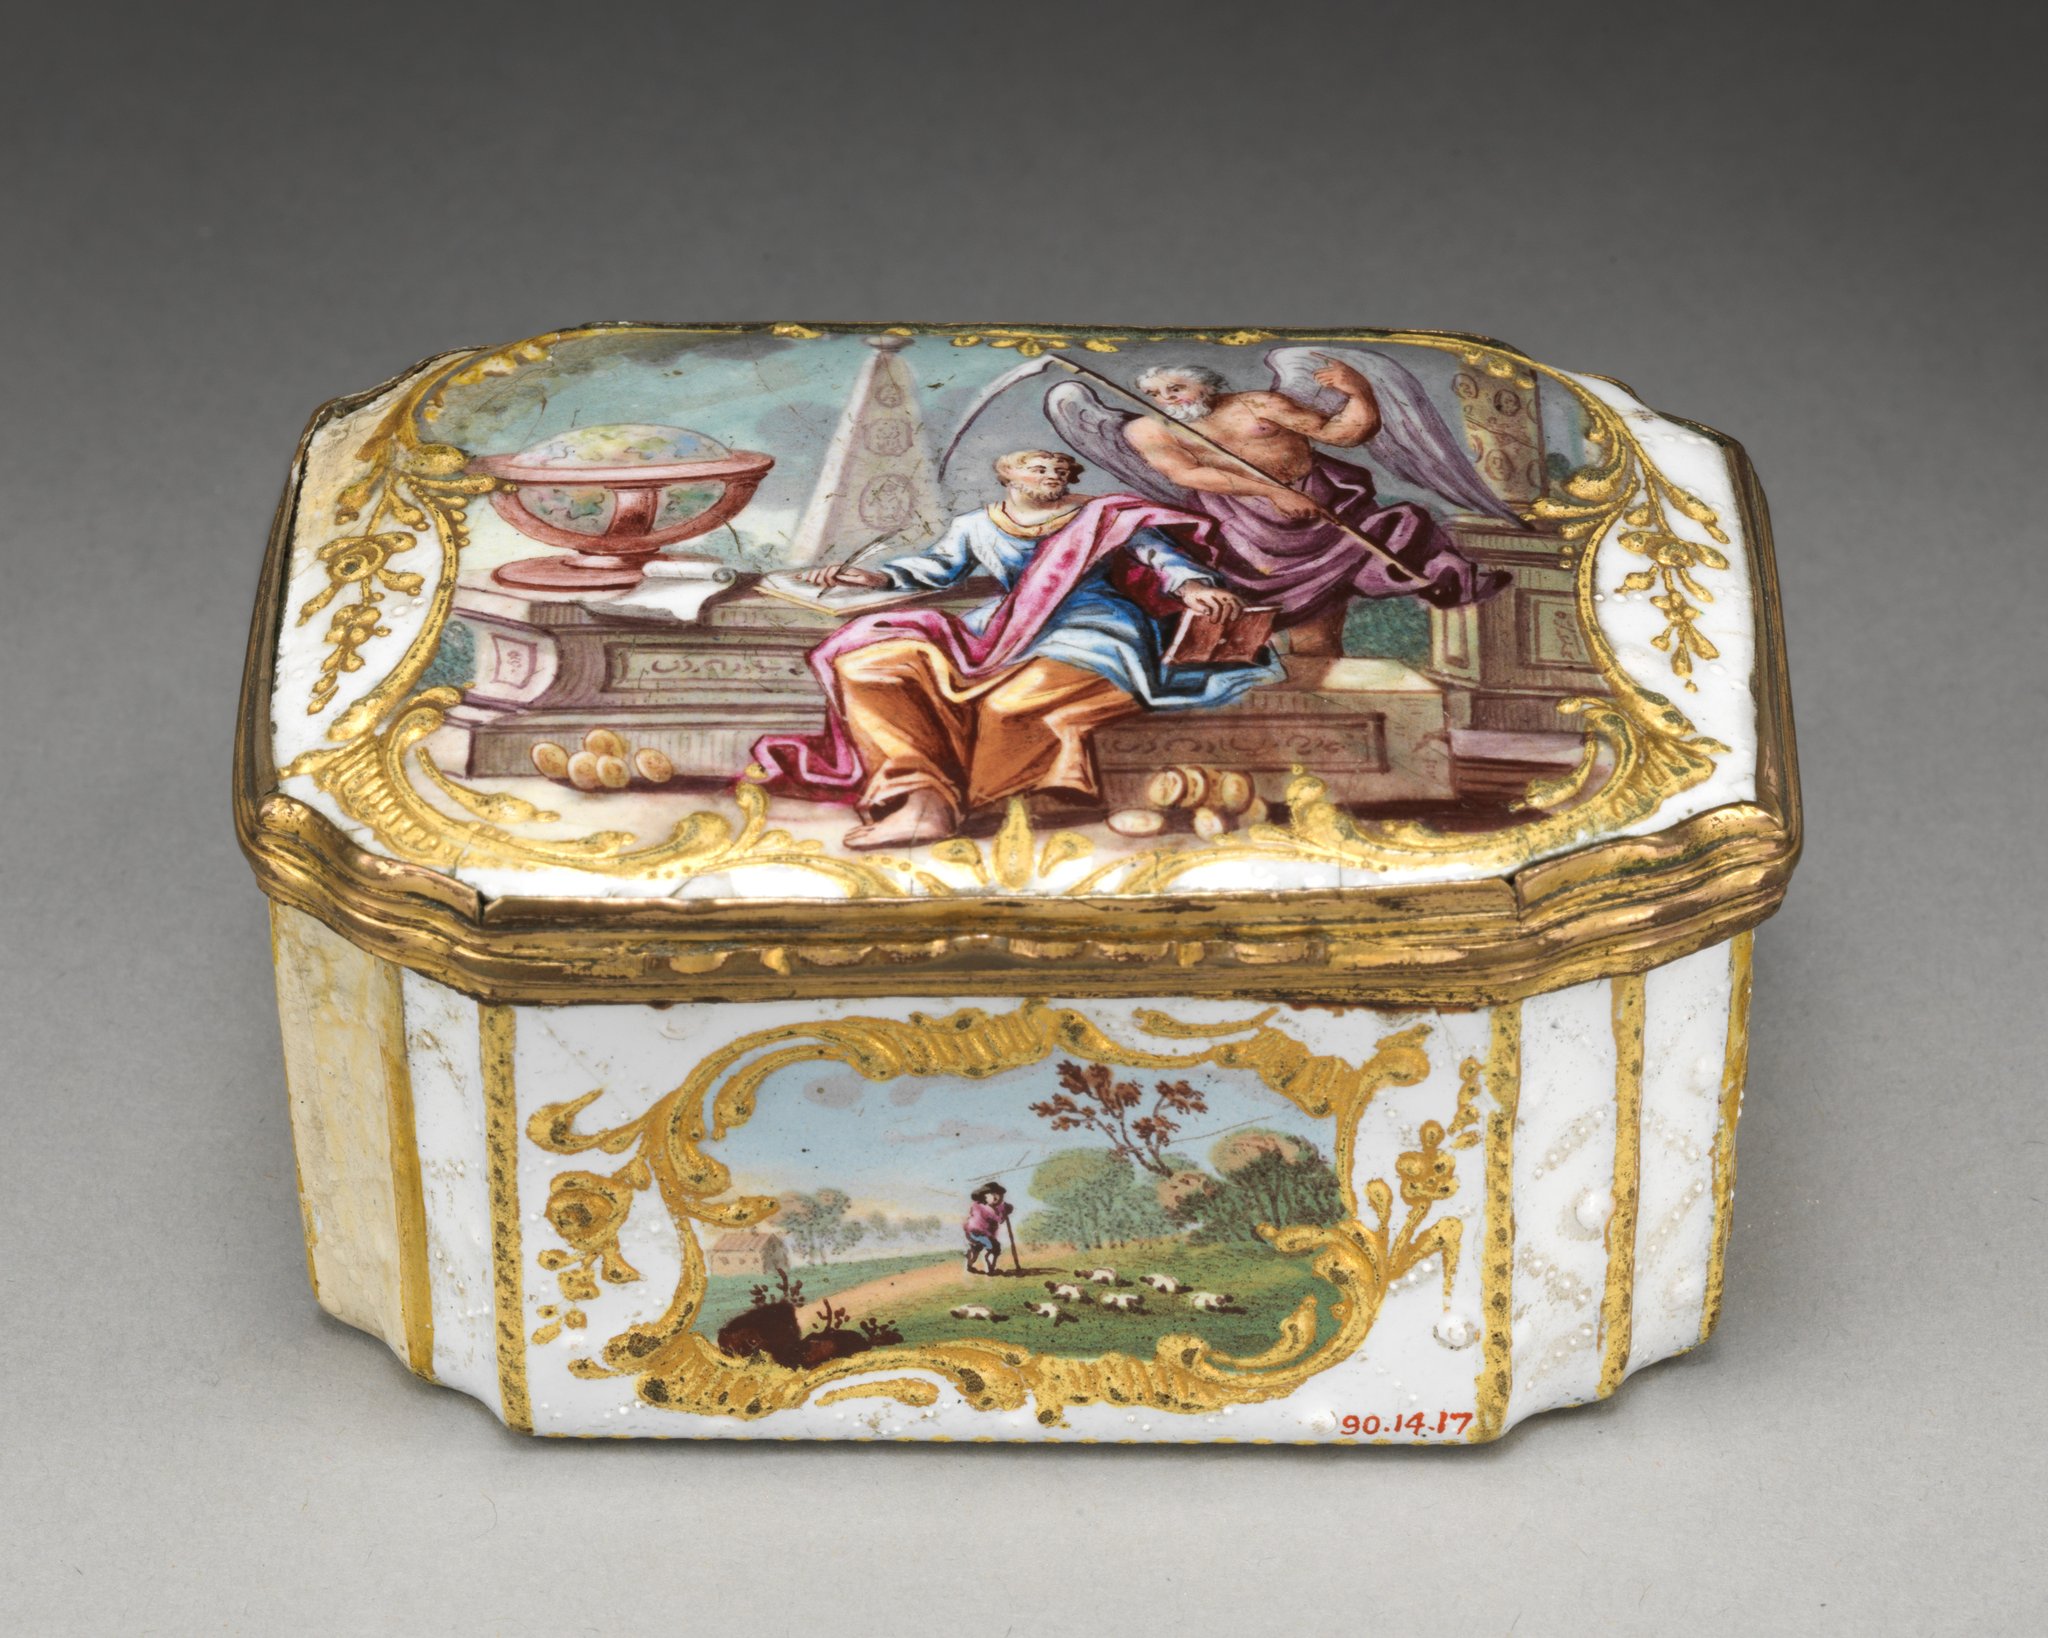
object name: snuffbox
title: Snuffbox with allegorical figures of History and Time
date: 1765-1770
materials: copper, enamel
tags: men,trees